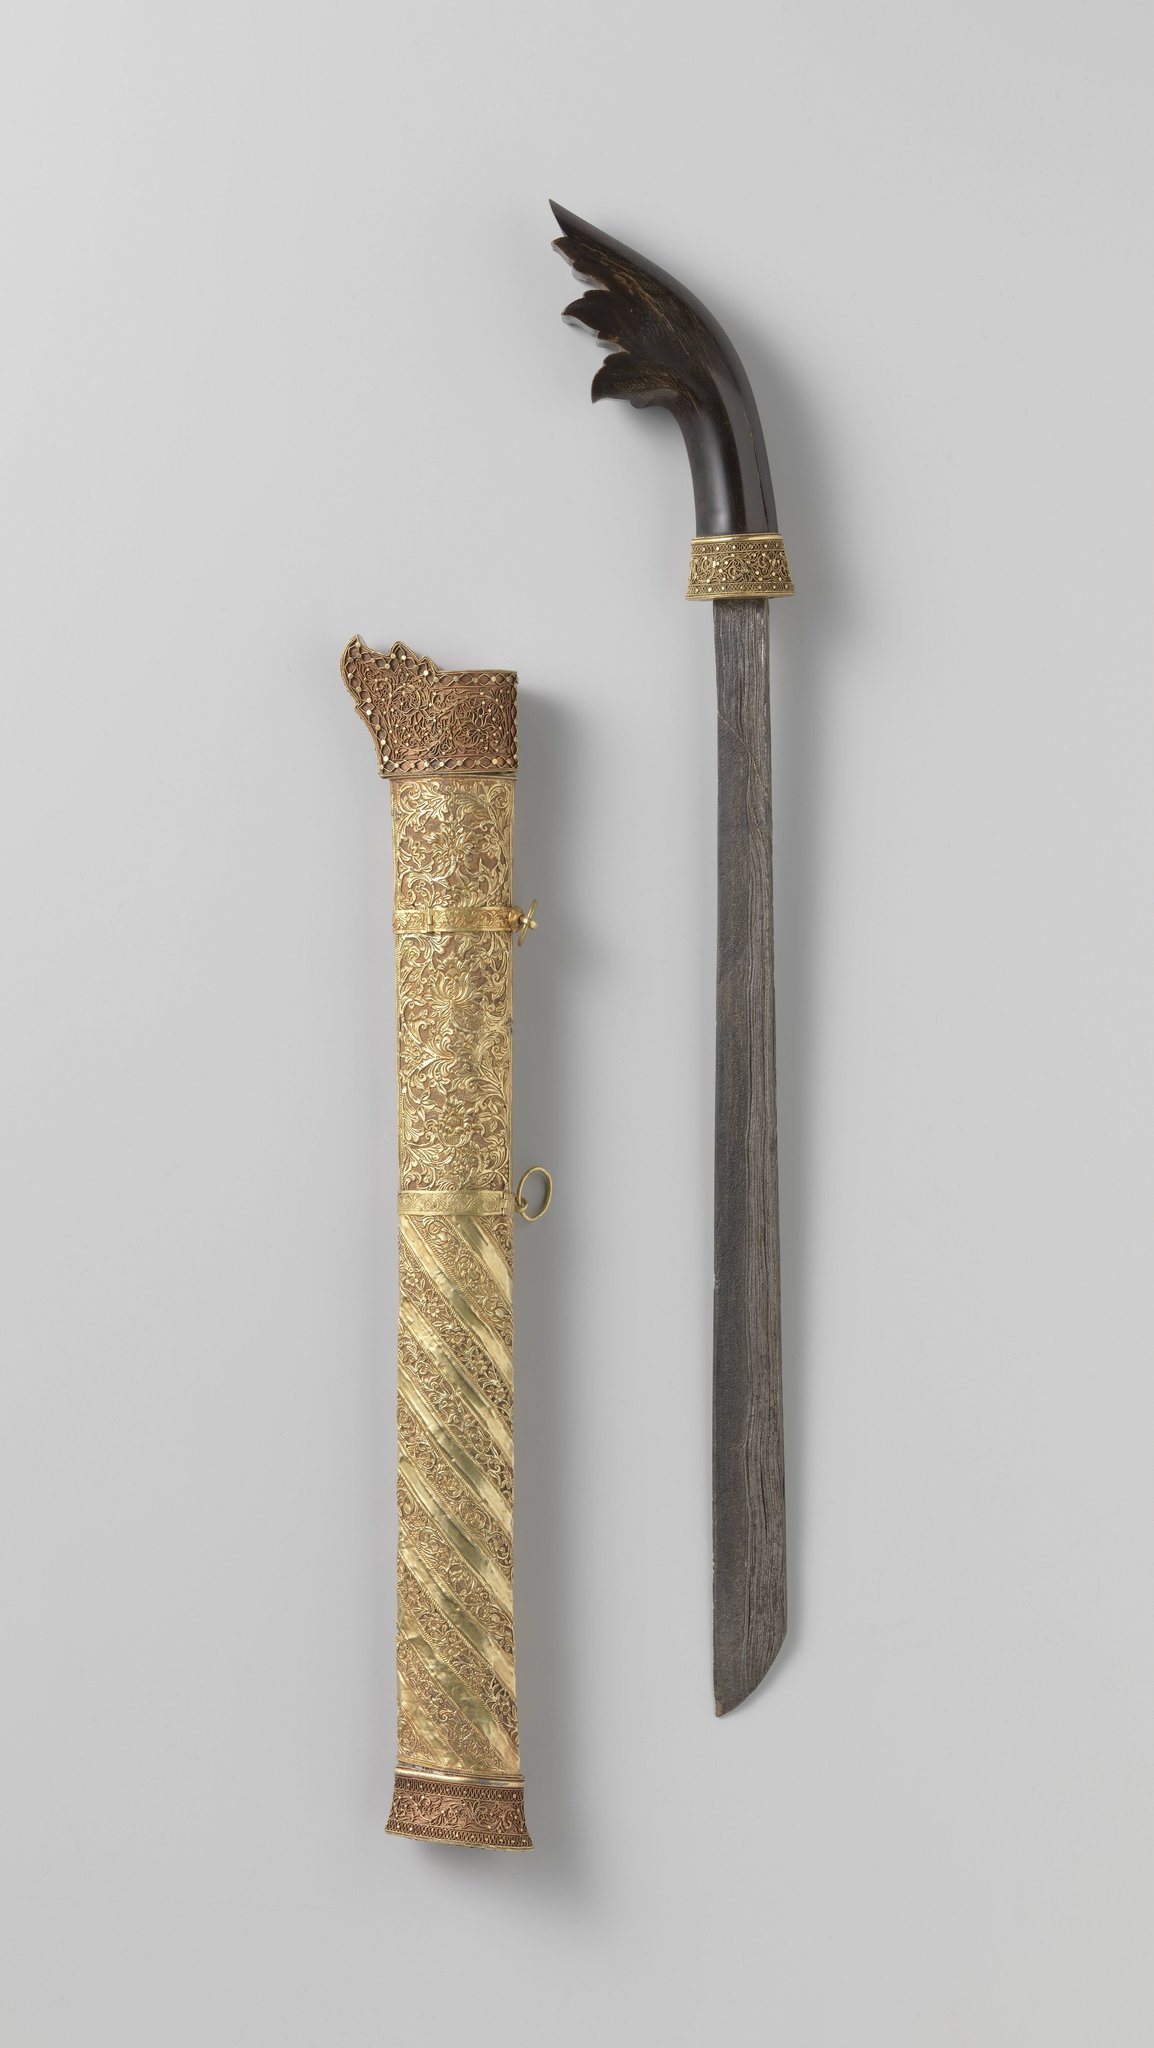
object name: kris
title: Chunderik met schede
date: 1600-1885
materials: gold, horn, metal, wood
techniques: cutting, forging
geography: dutch east indies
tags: dutch east indies, the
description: Dolk met oude éénsnijdende kling en teruglopend groen tot zwart hoornen gevest, om het gevest bij de kling een gouden vatting versierd met fijn smeedwerk in de vorm van ranken. Houten schede, geheel bedekt met bladgoud, boven en onder versierd met smeedwerk zoals op het gevest, de rest met gedreven plantmotieven. Op twee plaatsen rond de schede een band met draagoog en draagring.